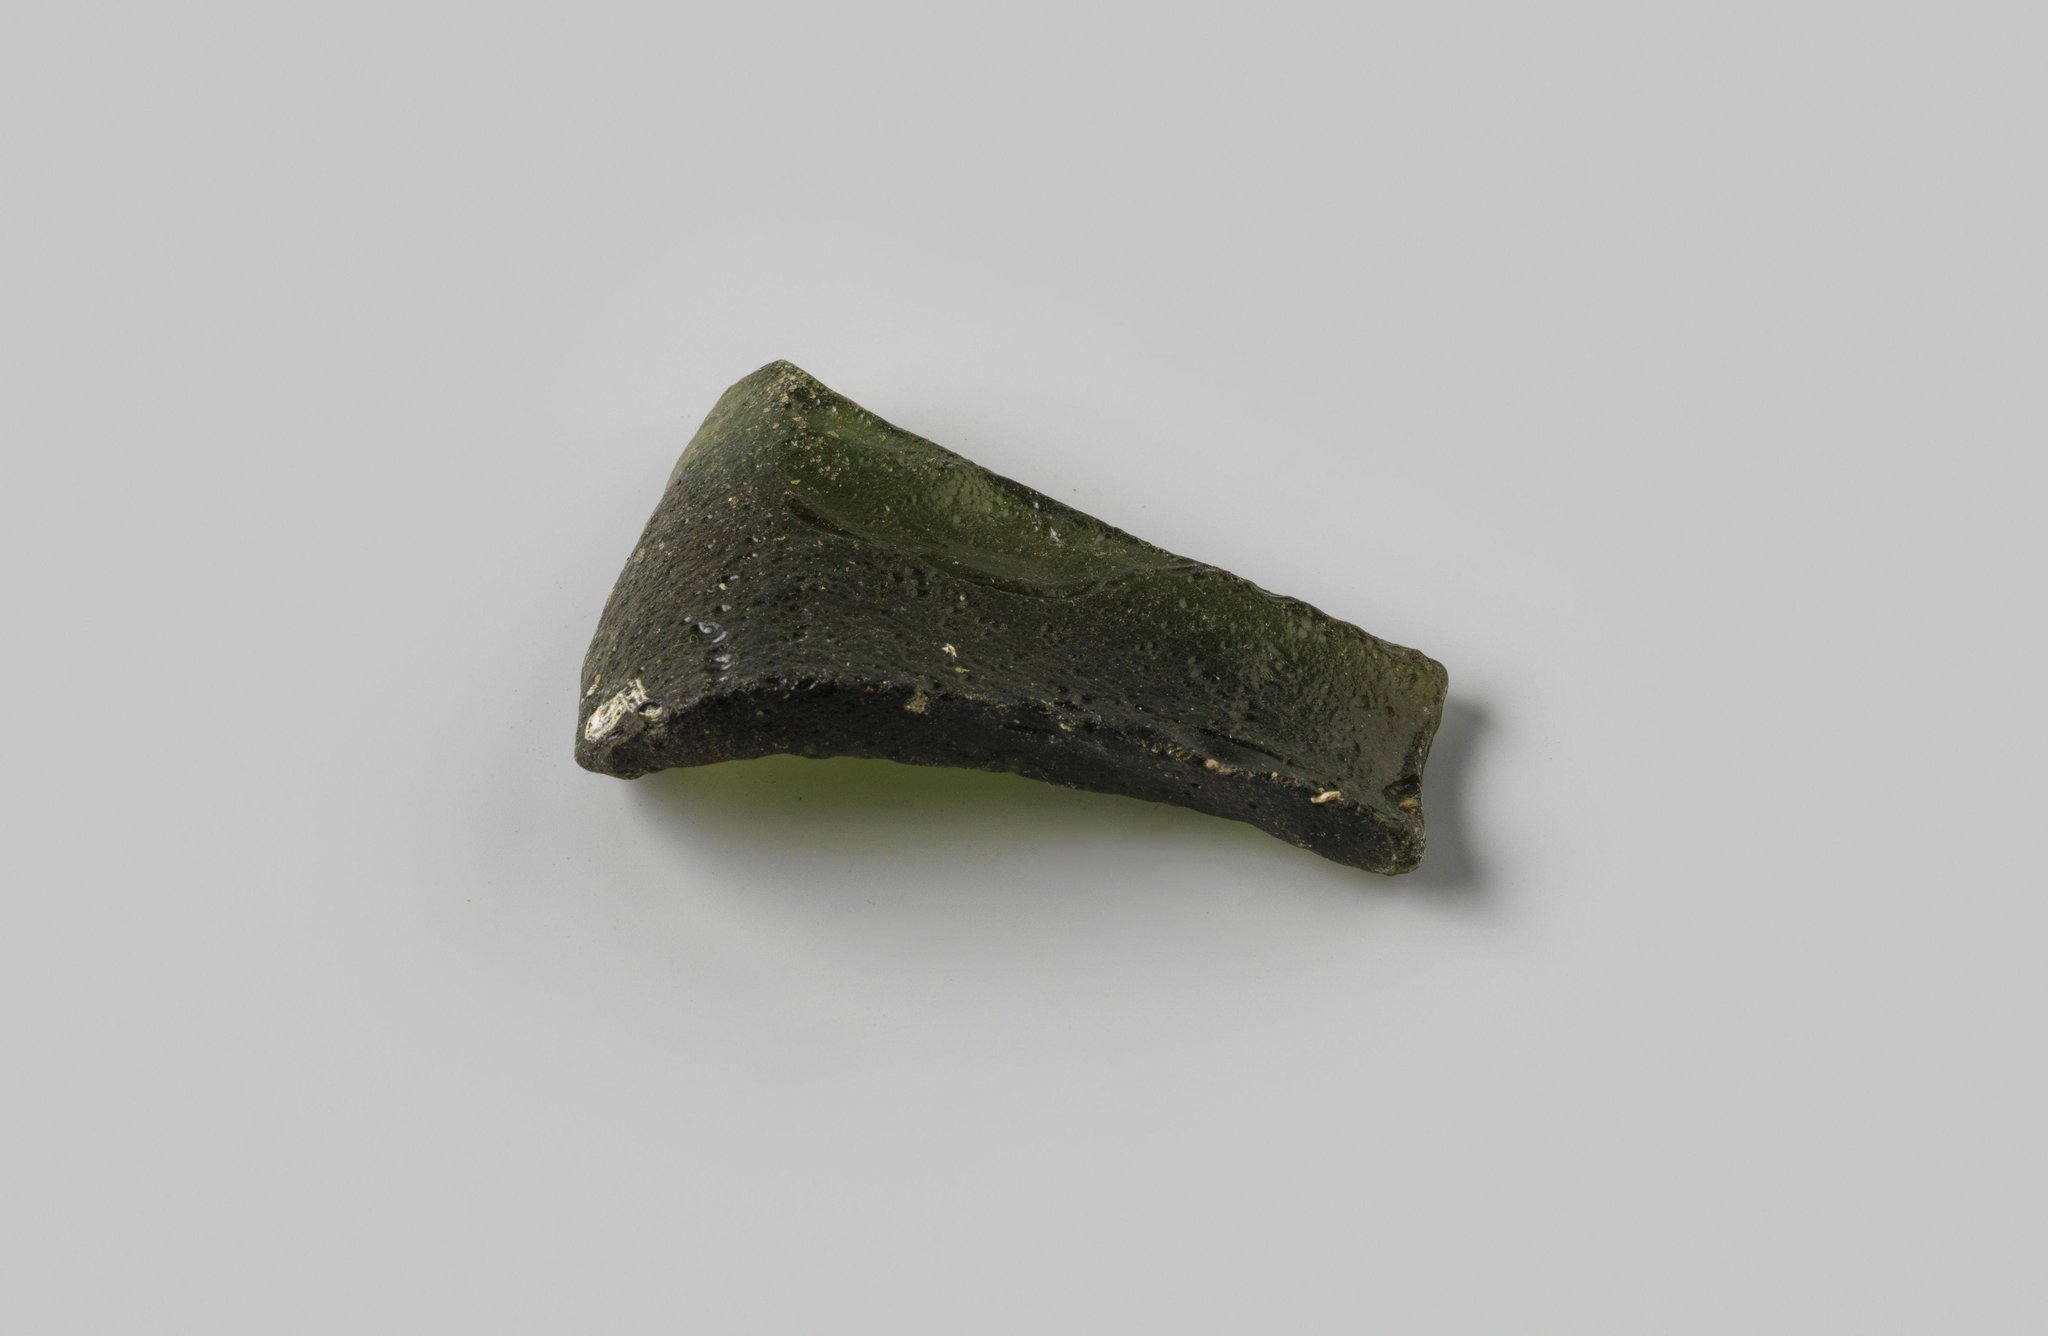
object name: wine bottle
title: Scherf van een wijnfles uit het wrak van de Oost-Indiëvaarder Hollandia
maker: Anonymous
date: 1700-1743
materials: glass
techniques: green glass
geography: netherlands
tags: verenigde oostindische compagnie, hollandia (schip), annet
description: Typologically not identifiable, base, fragm.